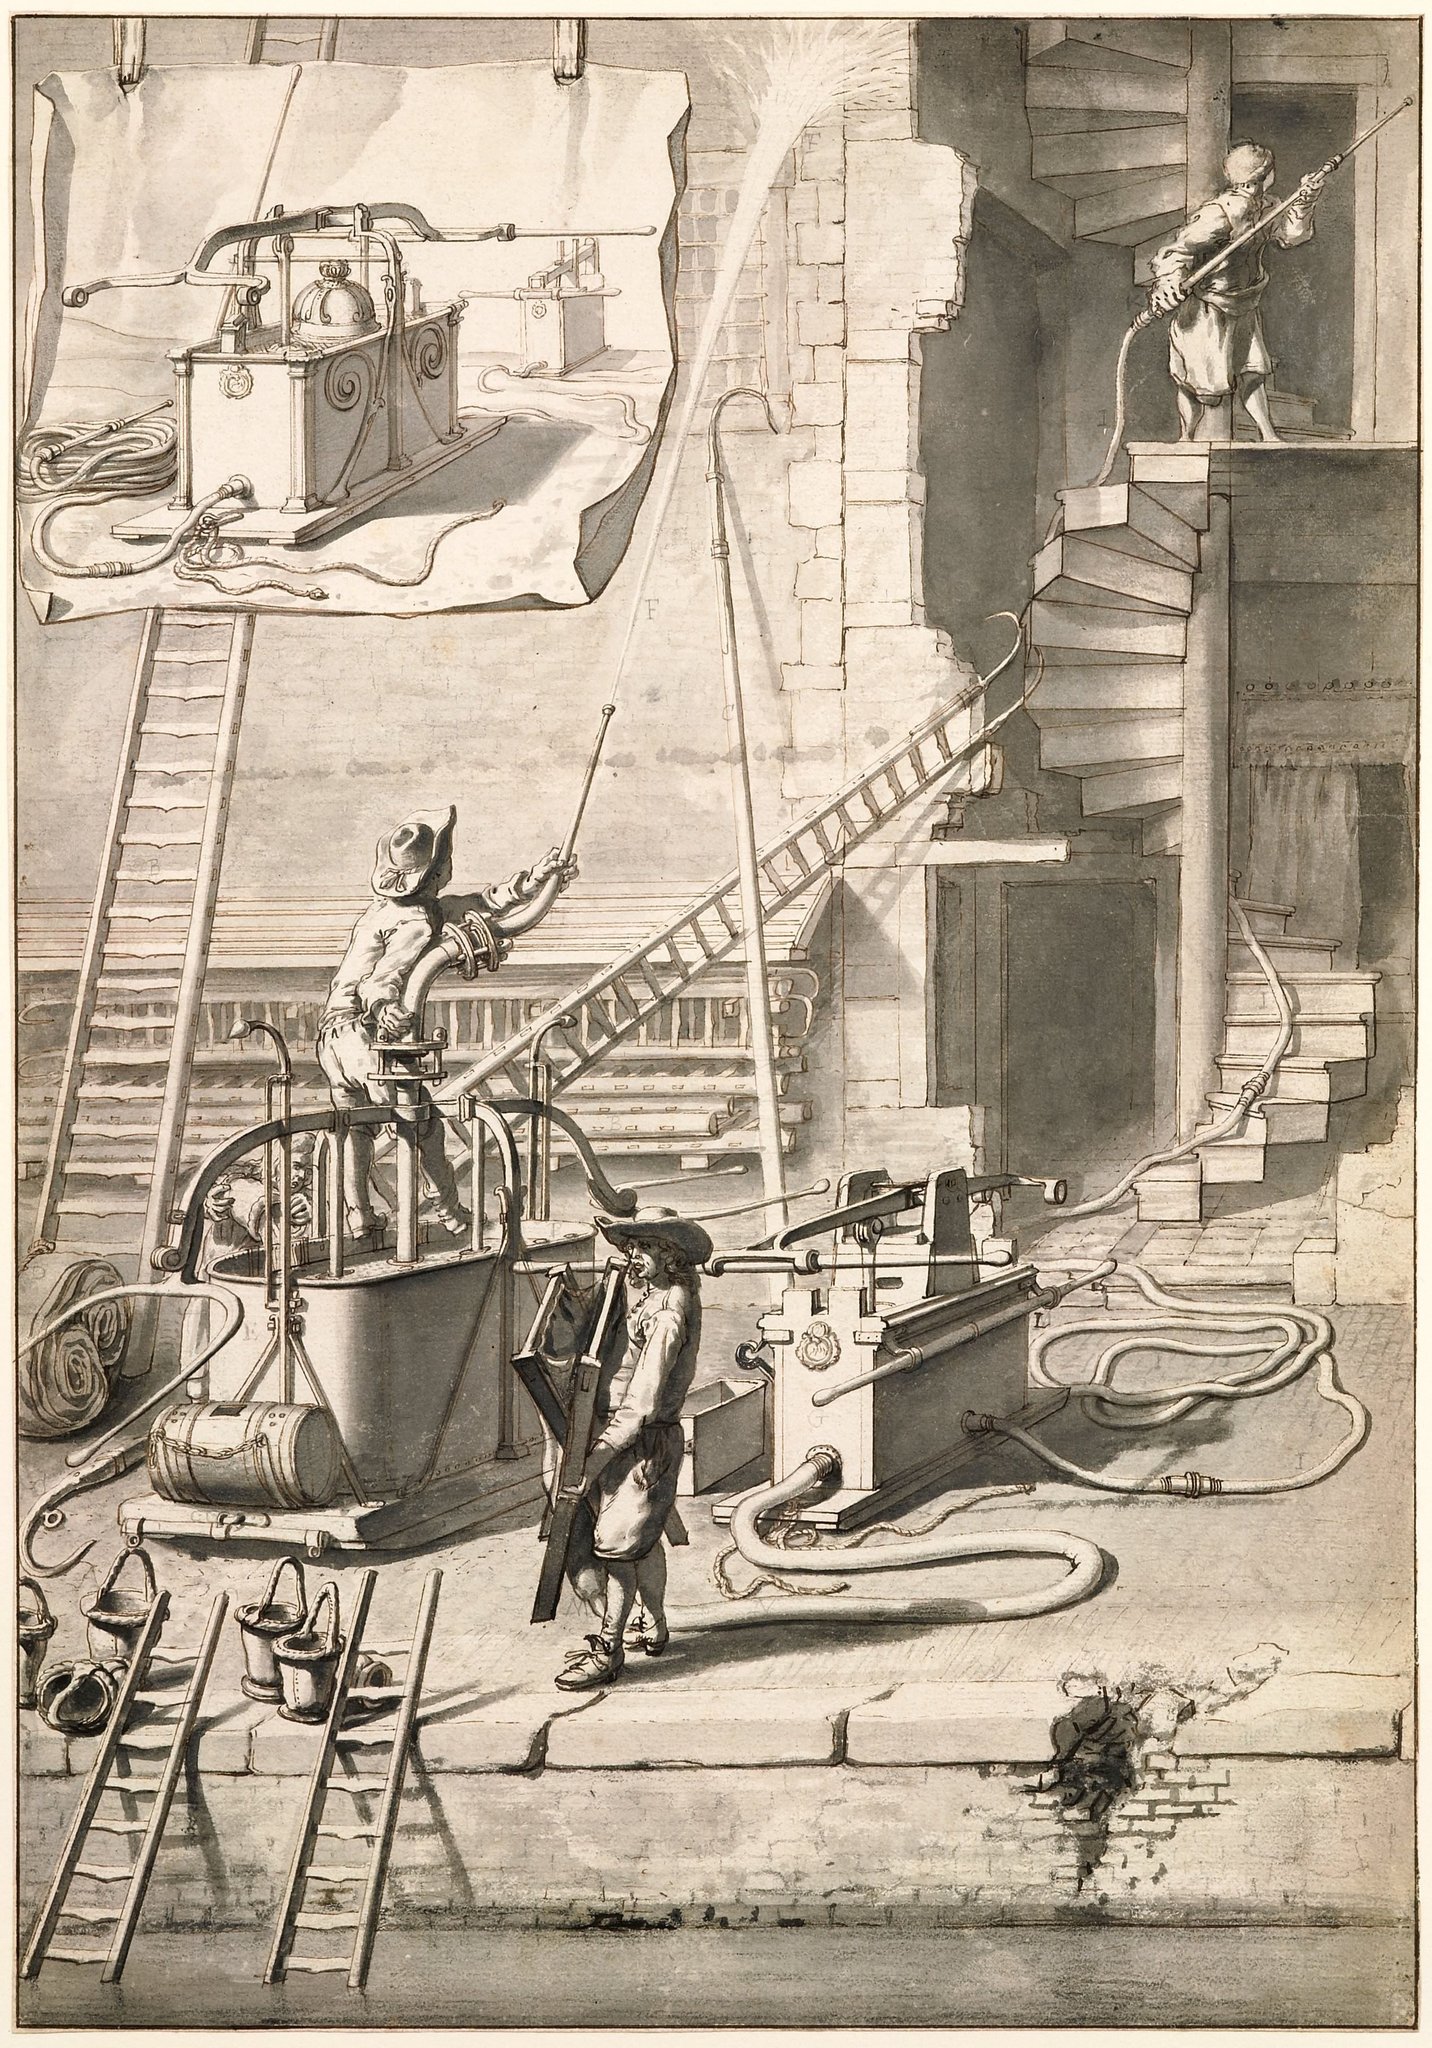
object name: drawing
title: Vergelijking van de oude brandspuiten met Van der Heydens slangenbrandspuit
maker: jan van der heyden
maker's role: draughtsman, painter, print maker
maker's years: 1637-1712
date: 1685-1690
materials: chalk, ink, paper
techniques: brush, pen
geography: northern netherlands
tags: amsterdam, painter, print maker, draughtsman, jan van der heyden, pails (fire-extinguishing equipment), fire-fighting, firemen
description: Ontwerptekening voor illustratie in: Jan van der Heyden, Beschryving der nieuwlyks uitgevonden en geoctrojeerde slang-brandspuiten, en haare wyze van brand-blussen, Jan Rieuwertsz (II), Amsterdam 1690.